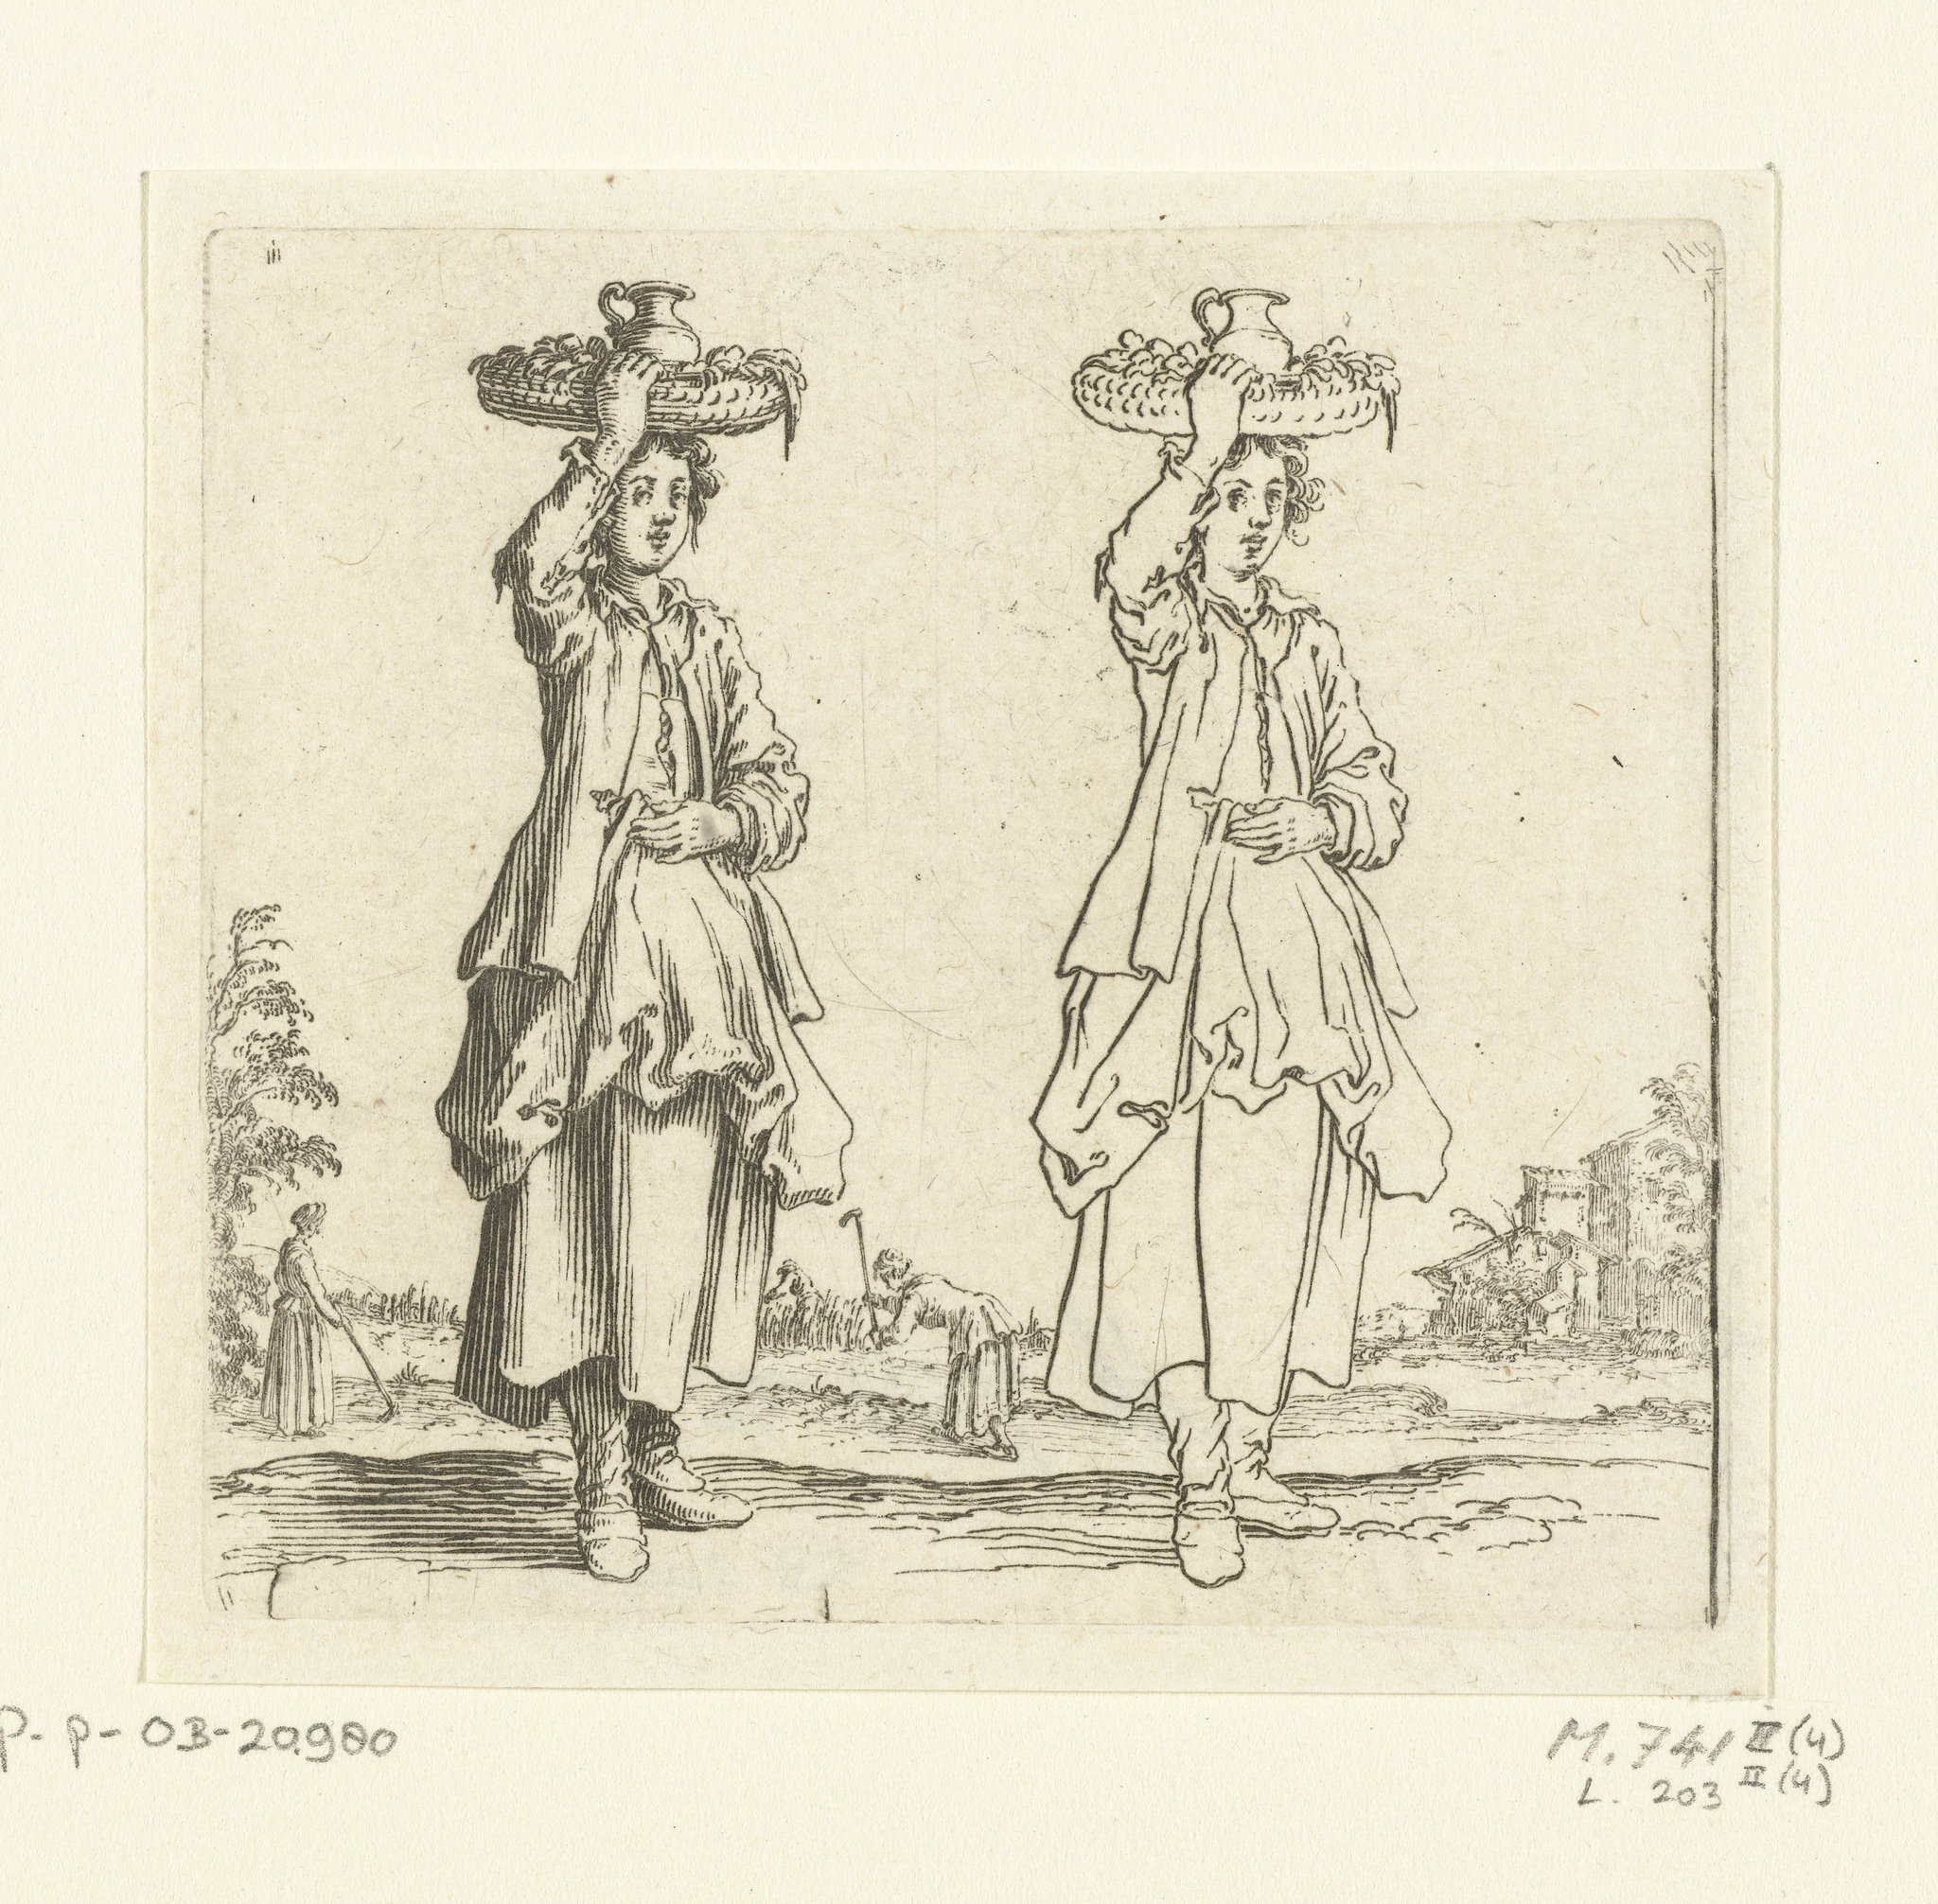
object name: print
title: Tweemaal dezelfde boerin met rieten mand, van voren gezien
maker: jacques callot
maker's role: draughtsman, print maker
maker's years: 1592-1635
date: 1621-1624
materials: paper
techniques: etching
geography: nancy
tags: farmers - aa - female farmer, farmer's wife, container made of plant material other than wood: basket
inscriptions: collector's mark: Lugt 240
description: Een boerin met een rieten mand op het hoofd, van voren gezien, tweemaal afgebeeld: rechts als lijnfiguur, links meer uitgewerkt met schaduwpartijen. Op de achtergrond enkele figuurtjes die een akker bewerken. Deze prent is onderdeel van een serie van 16 prenten (15 volgens Lieure; 17 resp. 16 incl. titelprent) met mannen en vrouwen in diverse houdingen. Mogelijk zijn deze prenten bedoeld geweest als tekenvoorbeelden.